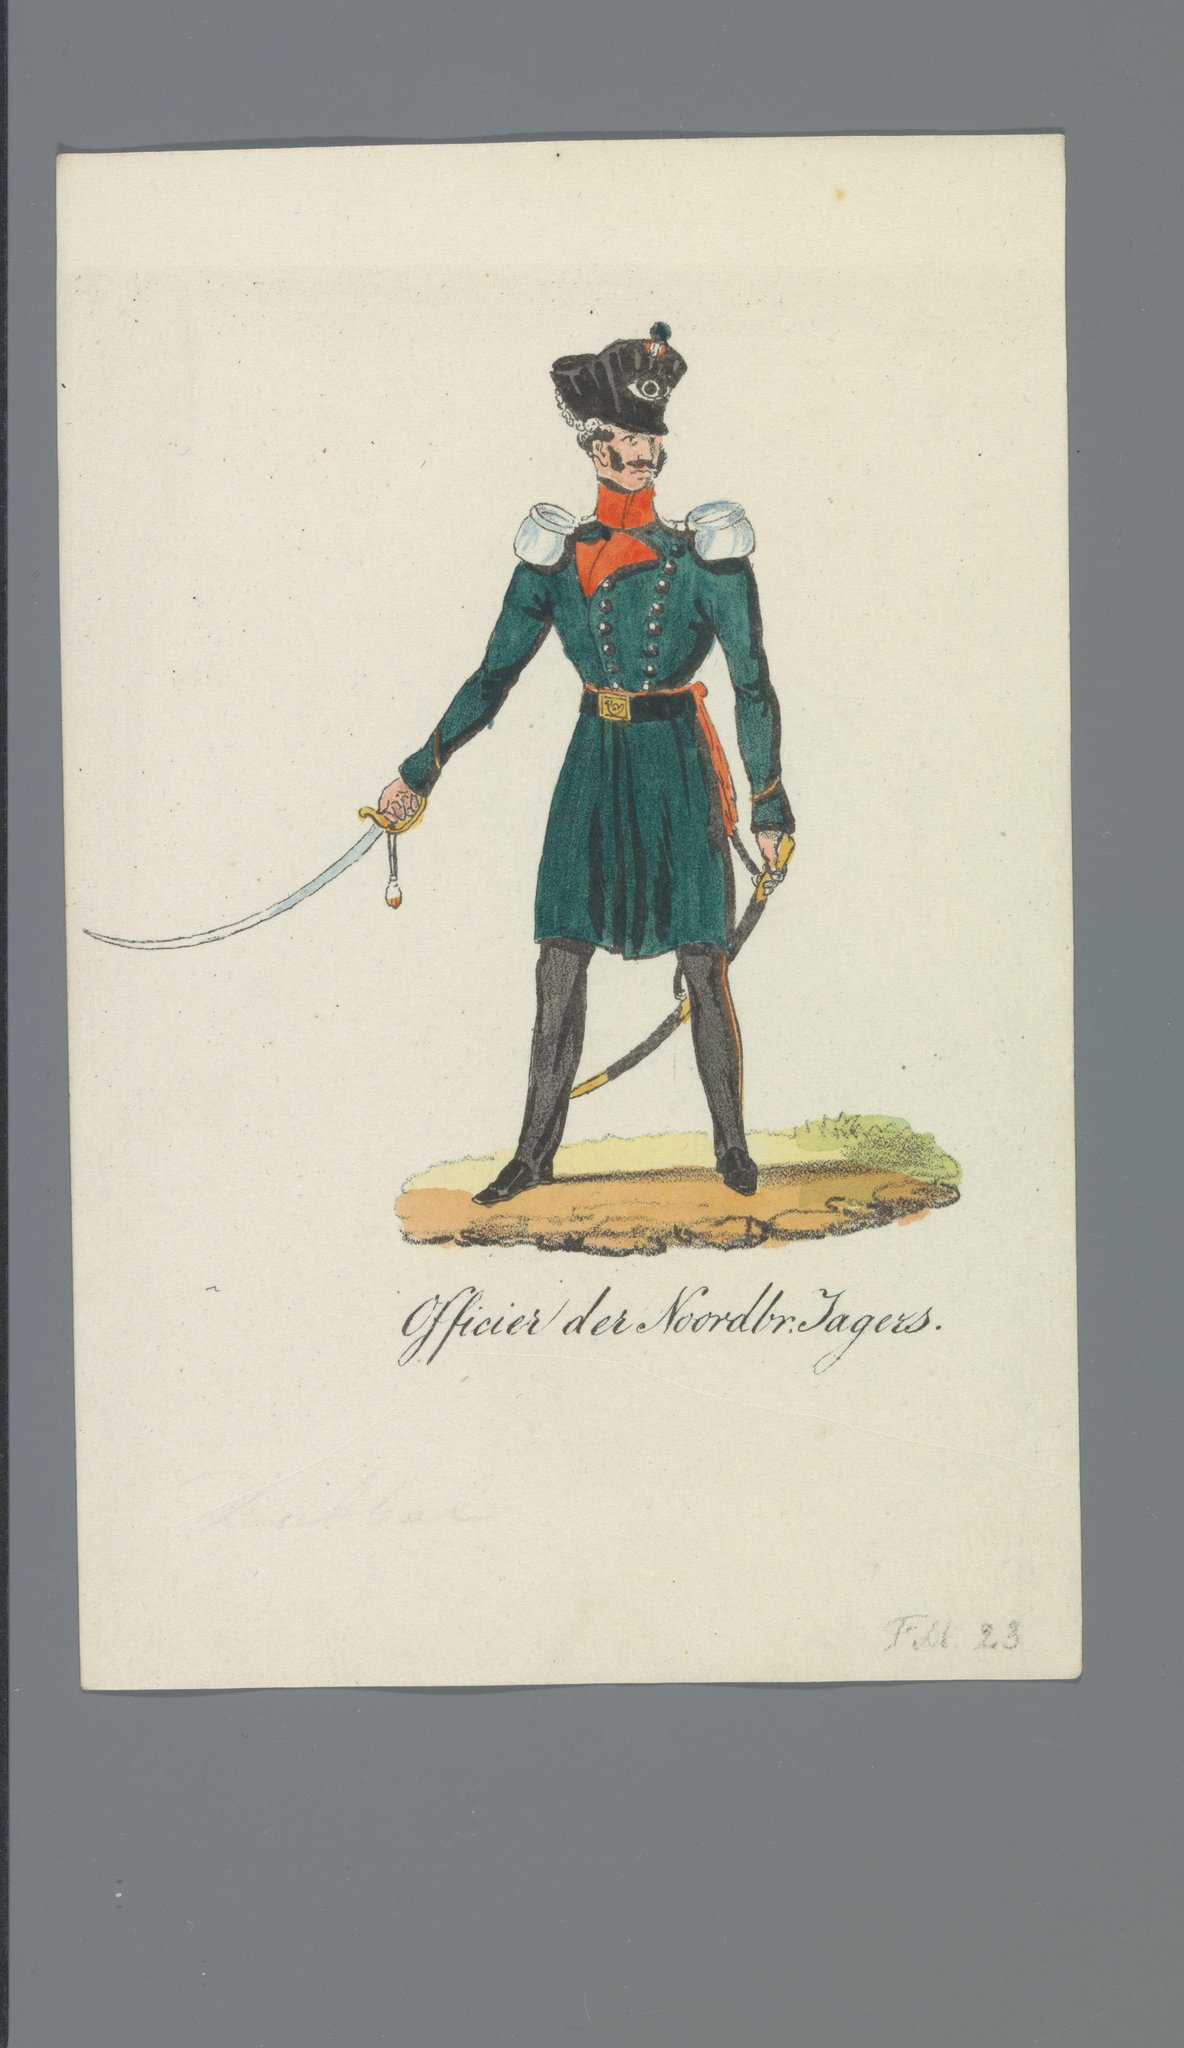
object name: costume print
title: Nederlandse militaire uniformen in de jaren 1830-1832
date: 1835-1850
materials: paper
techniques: hand coloring, lithograph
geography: utrecht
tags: (military) uniforms, clothes, costume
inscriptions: collector's mark: Lugt 2228, collector's mark: Lugt 2227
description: Staande officier van het Korps Noord-Brabantse Jagers. Met getrokken sabel. Onderdeel van een serie van 157 losse bladen met Nederlandse militaire uniformen in de jaren 1830-1832.